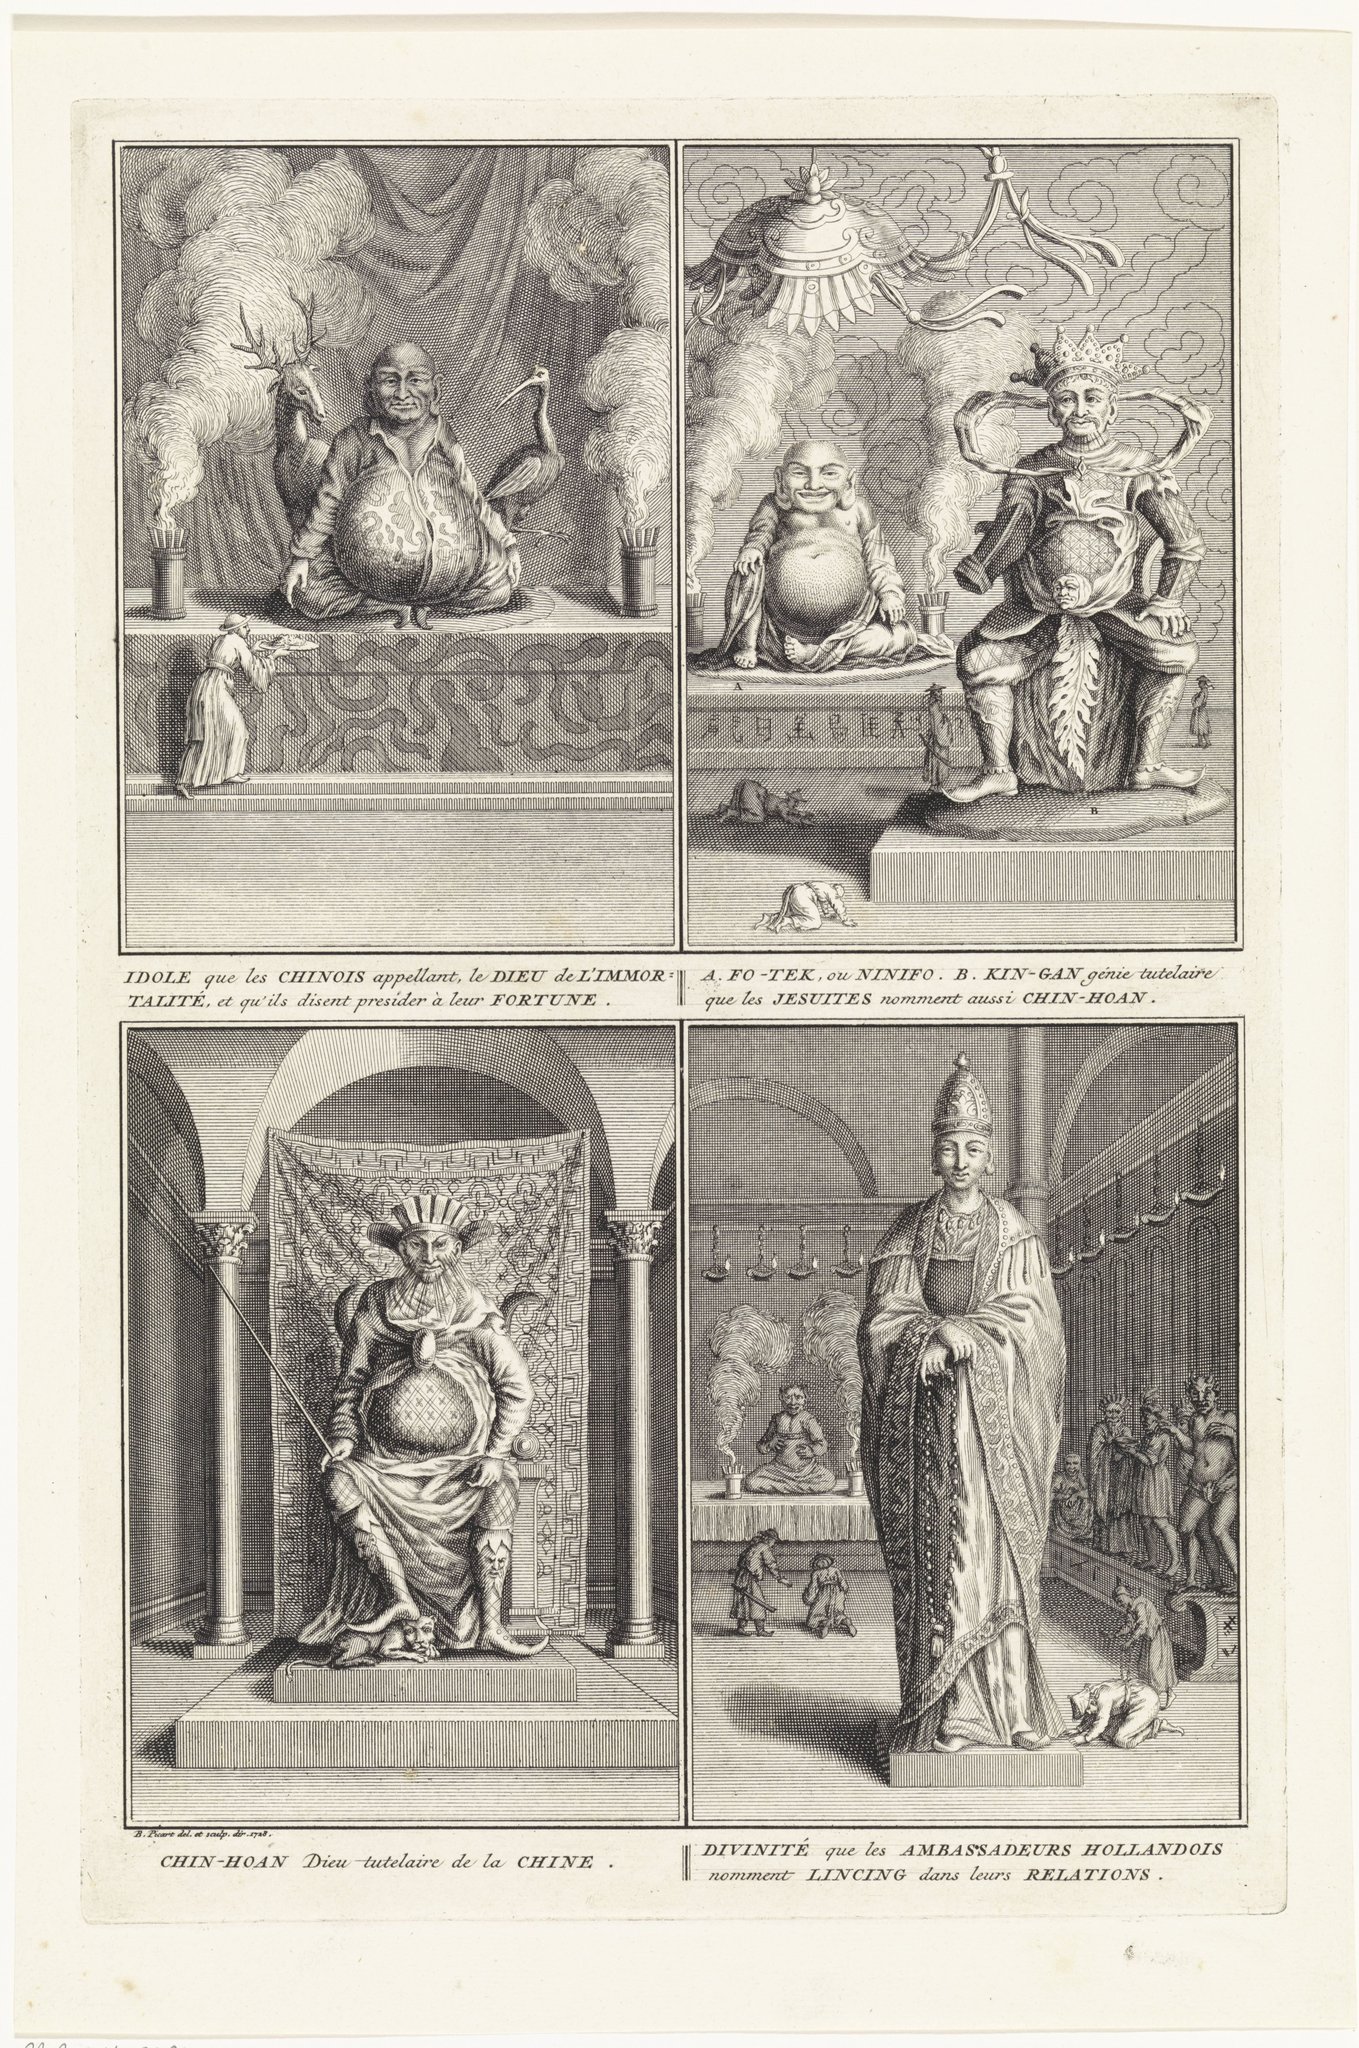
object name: print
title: Idole que le Chinois appelant le Dieu de l'Immortalité (...)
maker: bernard picart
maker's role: draughtsman, print maker, publisher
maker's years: 1673-1733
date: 1728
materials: paper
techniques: engraving, etching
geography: amsterdam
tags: representations ~ gods, demi-gods, heroes, etc. (traditional chinese religions)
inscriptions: collector's mark: Lugt 2228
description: Blad met vier voorstellingen van Chinese godenbeelden. Linksboven: De god van de onsterfelijkheid. Rechtsboven: Twee goden. Op de achtergrond Fo-Tek of Ninifo. Op de voorgrond Kin-Gan, die door de Jezuieten Chin-Hoan wordt genoemd. Linksonder: Chin-Hoan, de beschermgod van China. Rechtsonder: Een beeld van Lin-Ching, waarvoor twee mensen knielen.